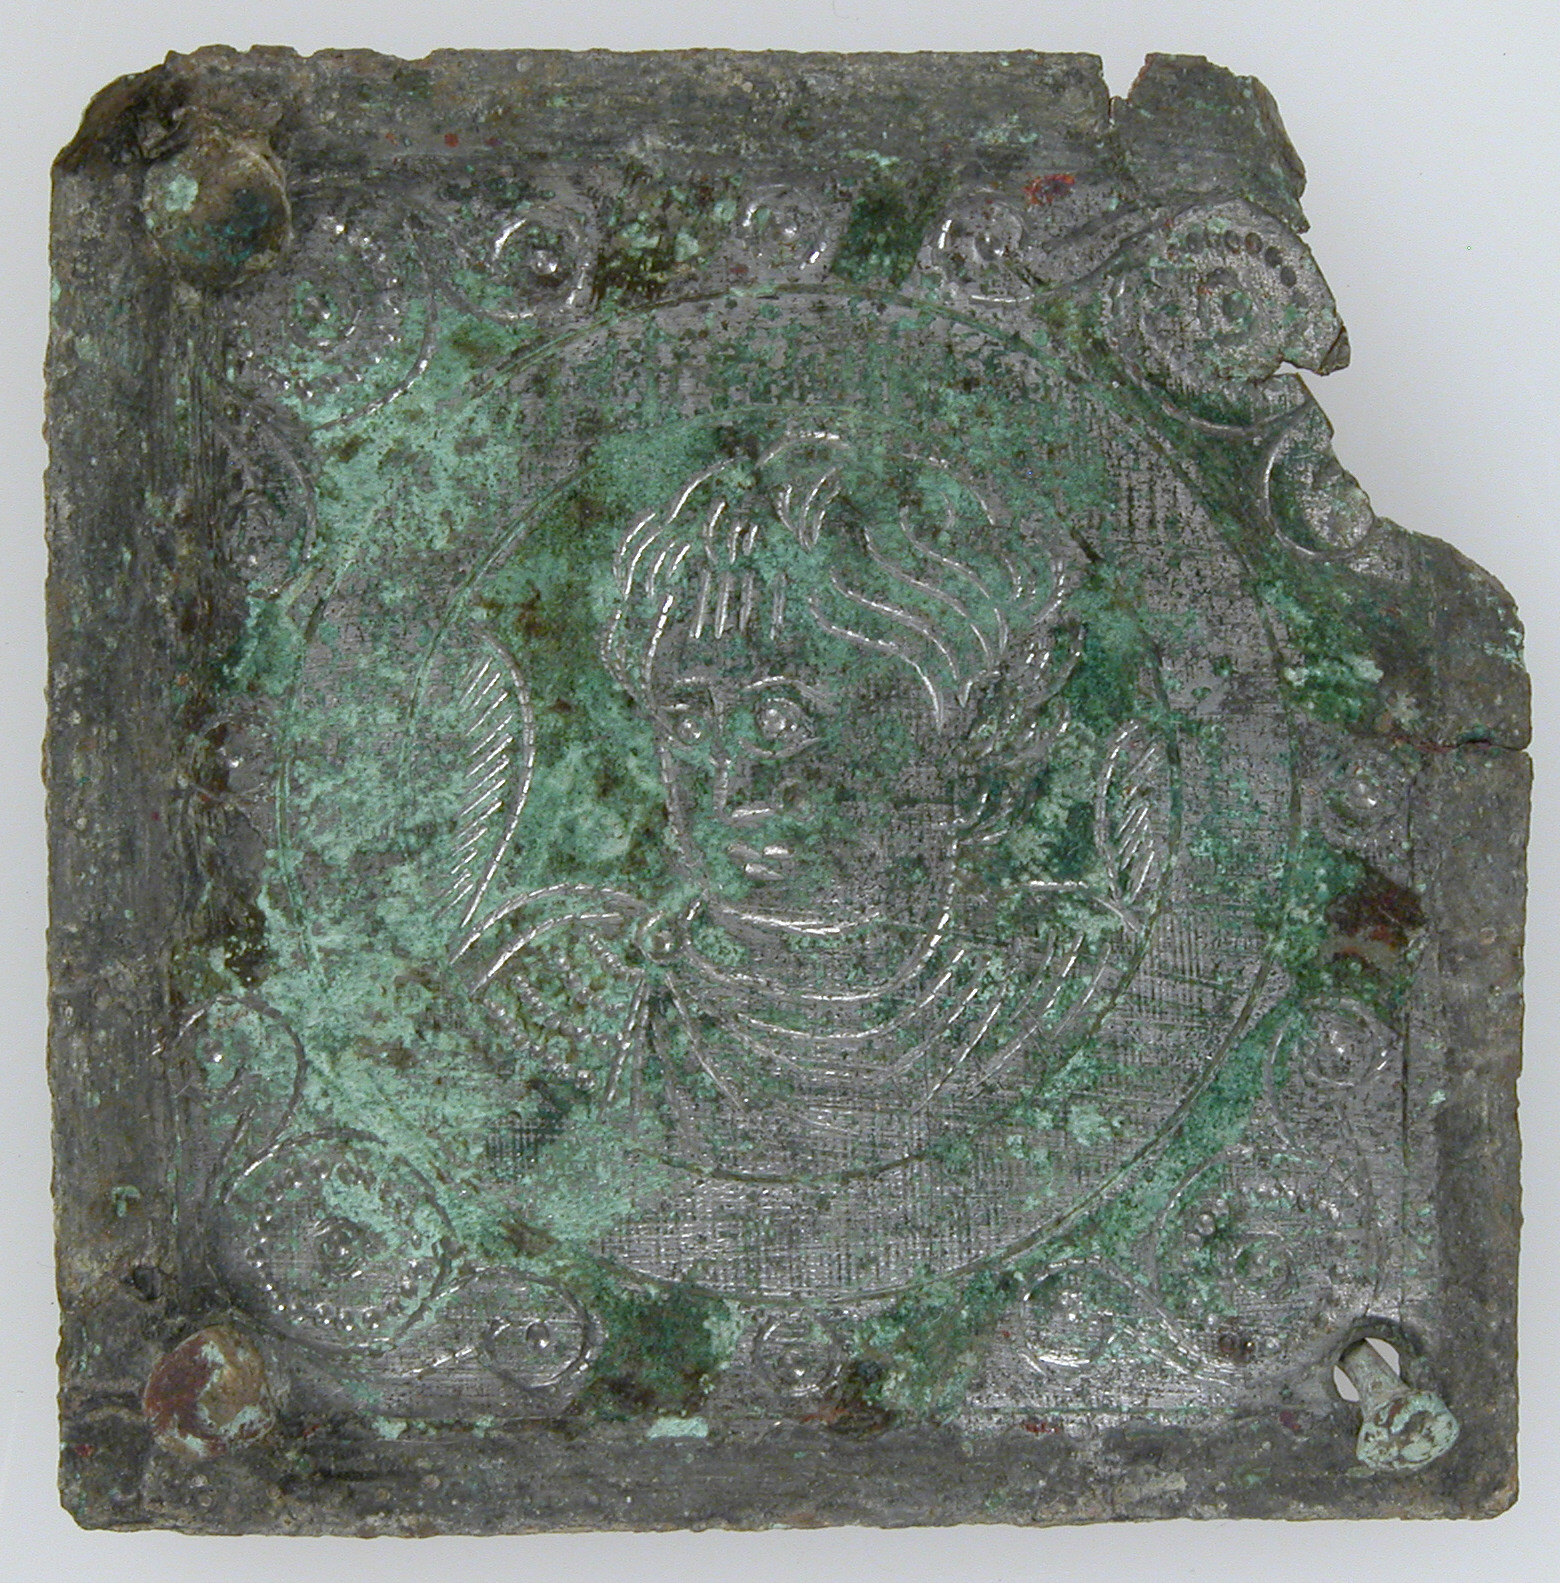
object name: plaque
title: Tinned-Copper Plaque with a Personification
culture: byzantine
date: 350-400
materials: copper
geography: italy